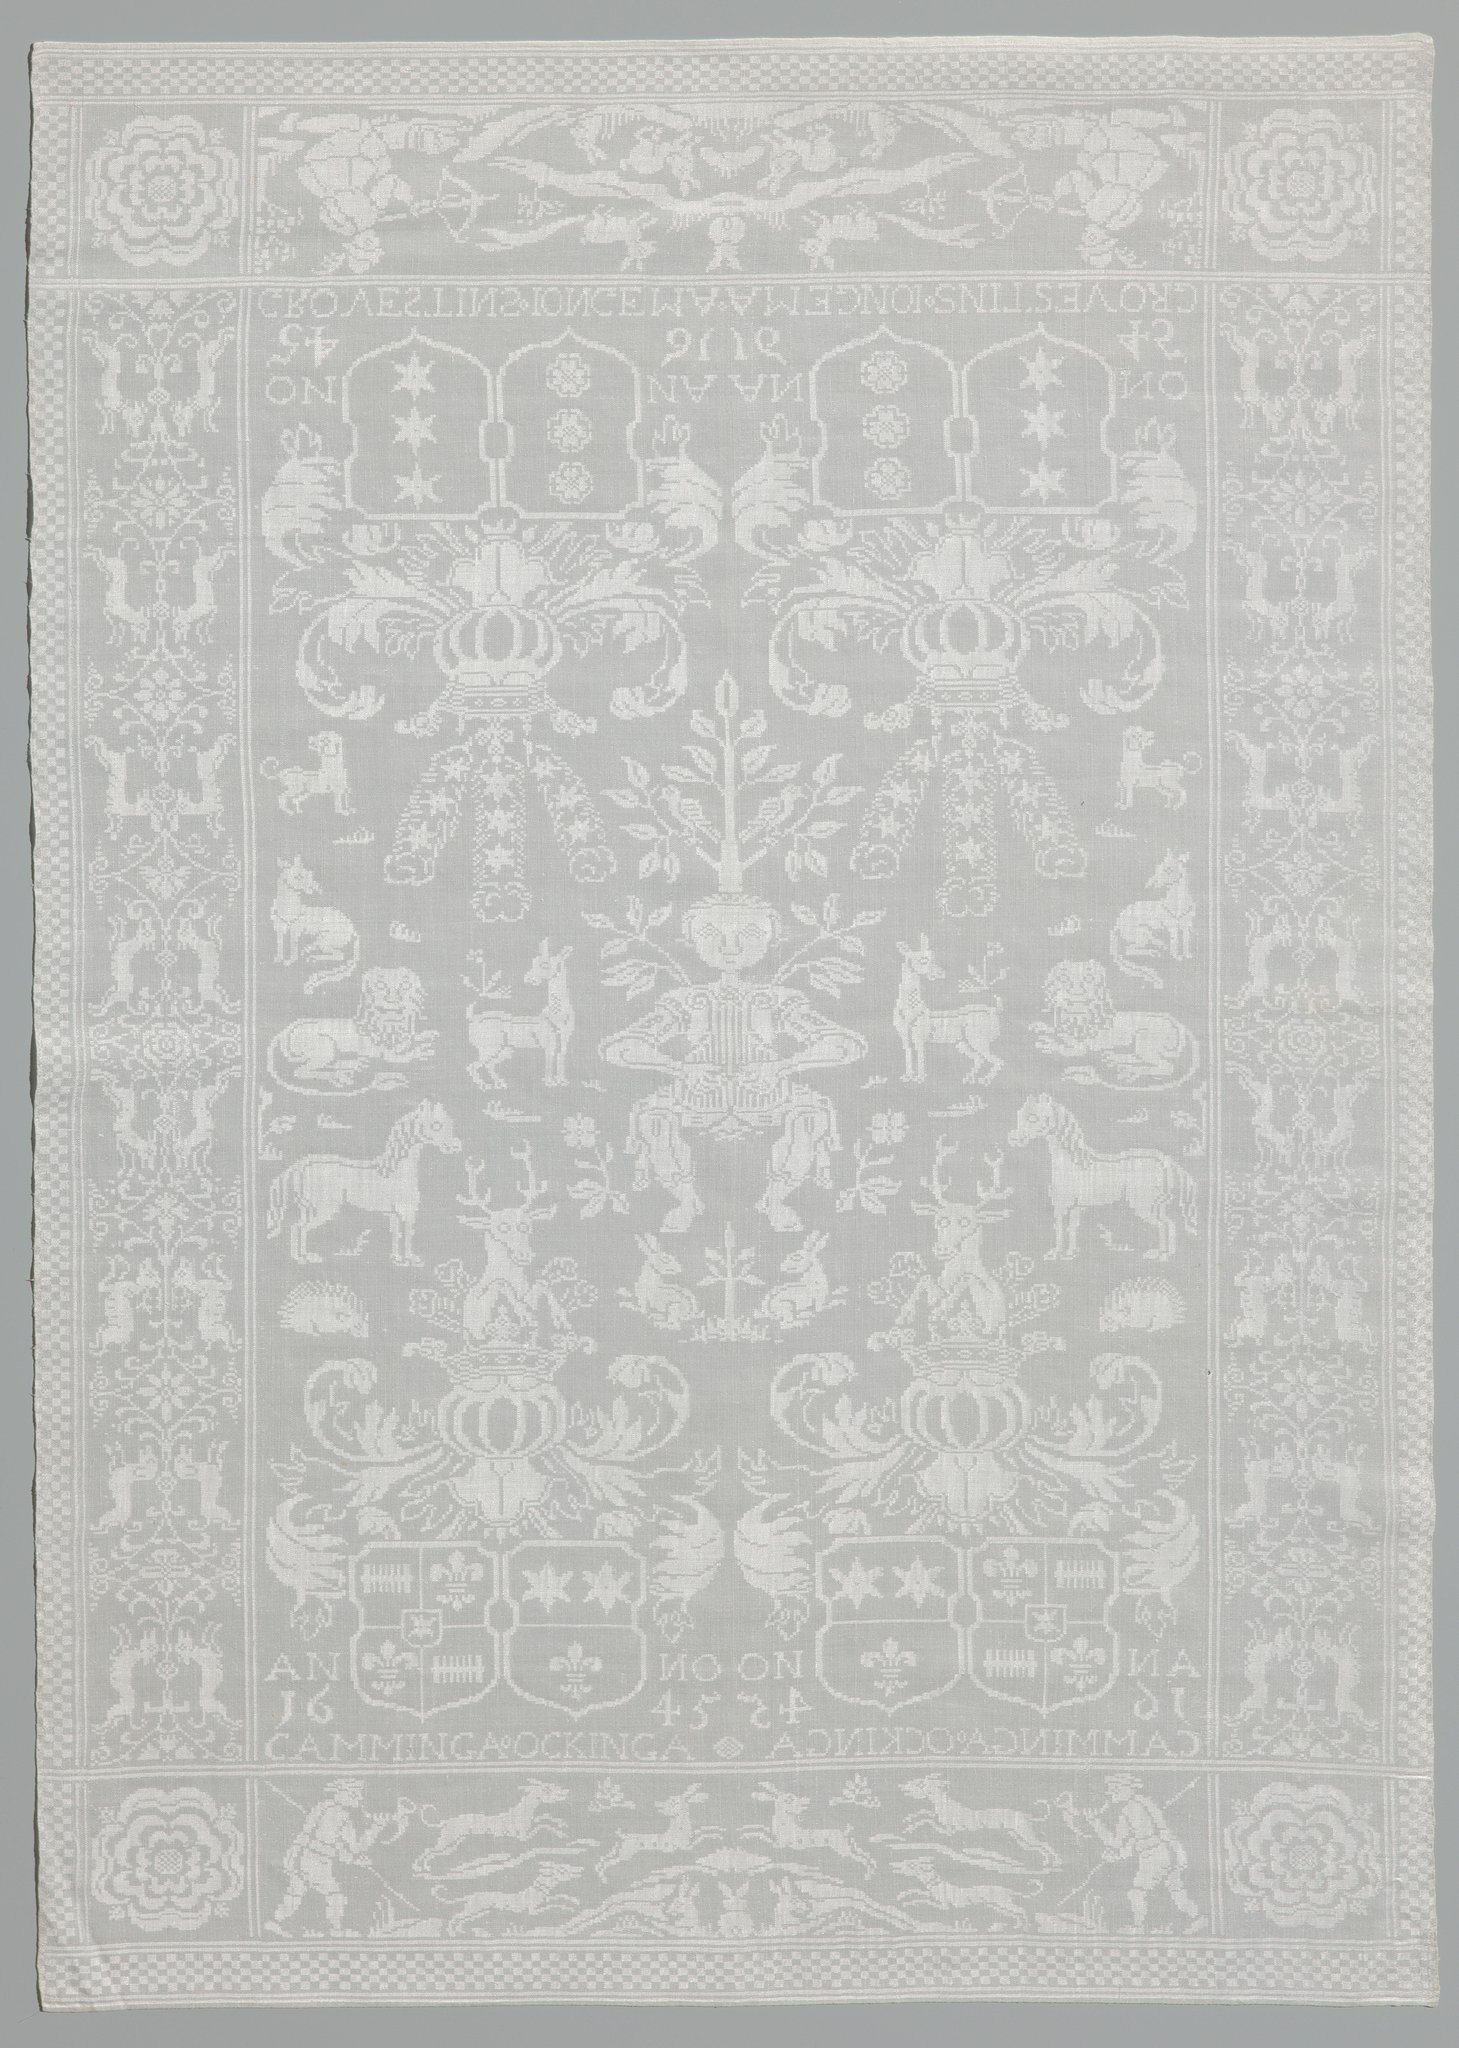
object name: dekservet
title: Dekservet met Friese wapens en Orpheus te midden van de dieren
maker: quirijn jansz. damast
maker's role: mayor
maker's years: 1580-1638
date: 1645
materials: linen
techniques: damask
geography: haarlem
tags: orpheus playing the lyre: trees and rocks move, beasts and birds are enchanted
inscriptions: date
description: Dekservet van linnendamast. Tweemaal het servettenpatroon recht boven elkaar, binnen vier randen.